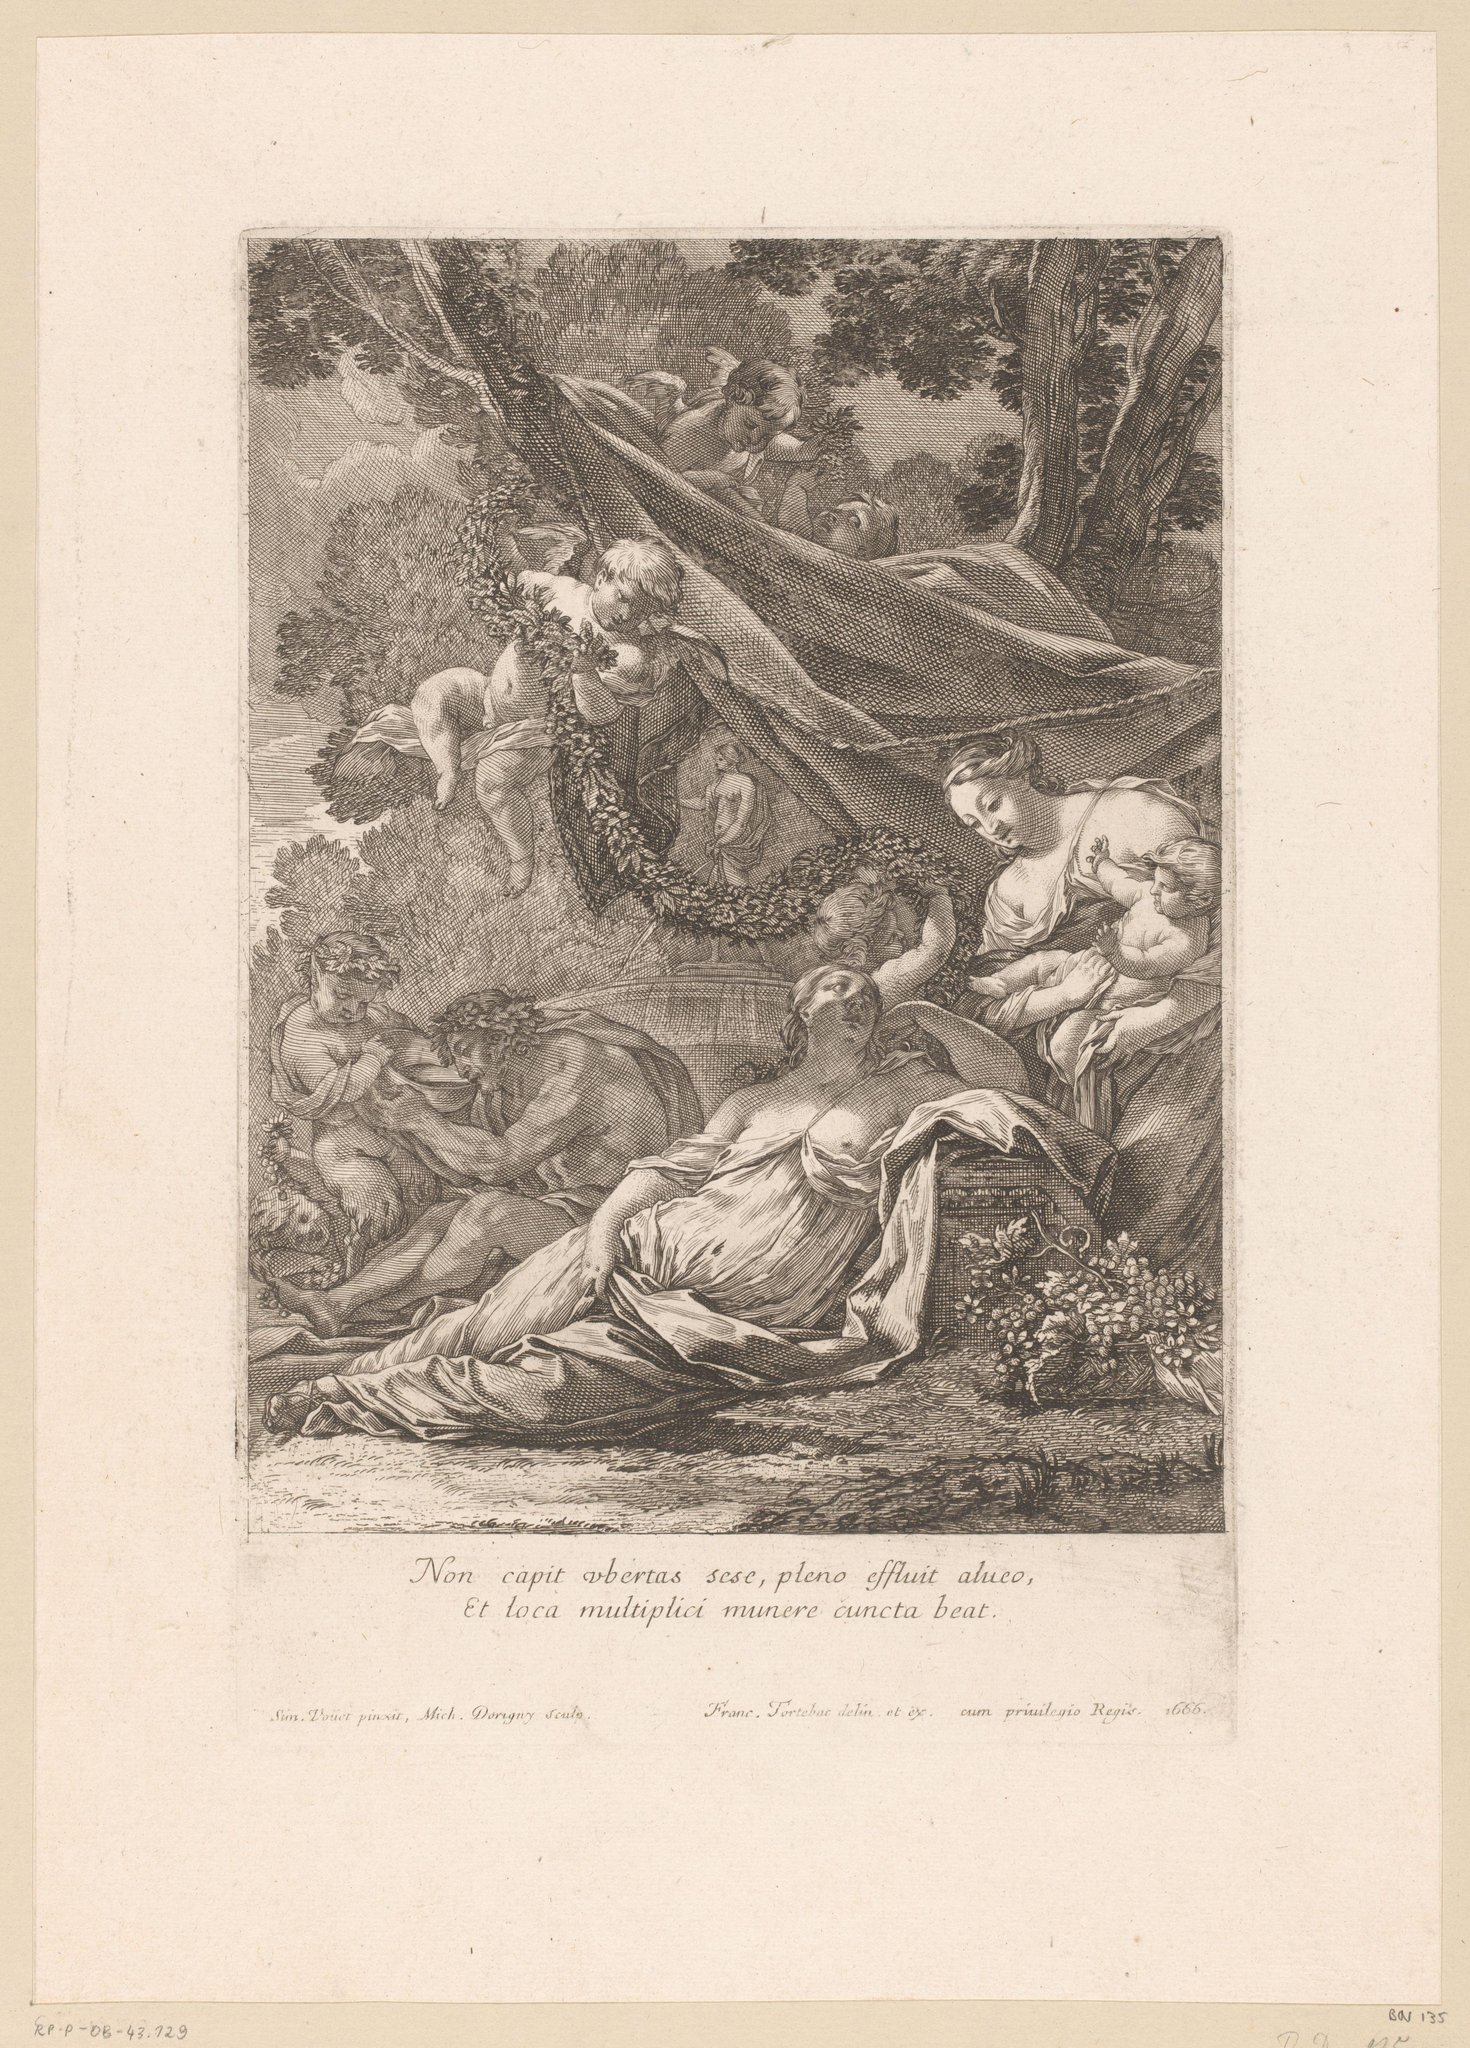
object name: print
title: Allegorische voorstelling over overvloedigheid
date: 1666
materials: paper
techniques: engraving, etching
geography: france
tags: abundantia (abundance) as roman personification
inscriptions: collector's mark: Lugt 240